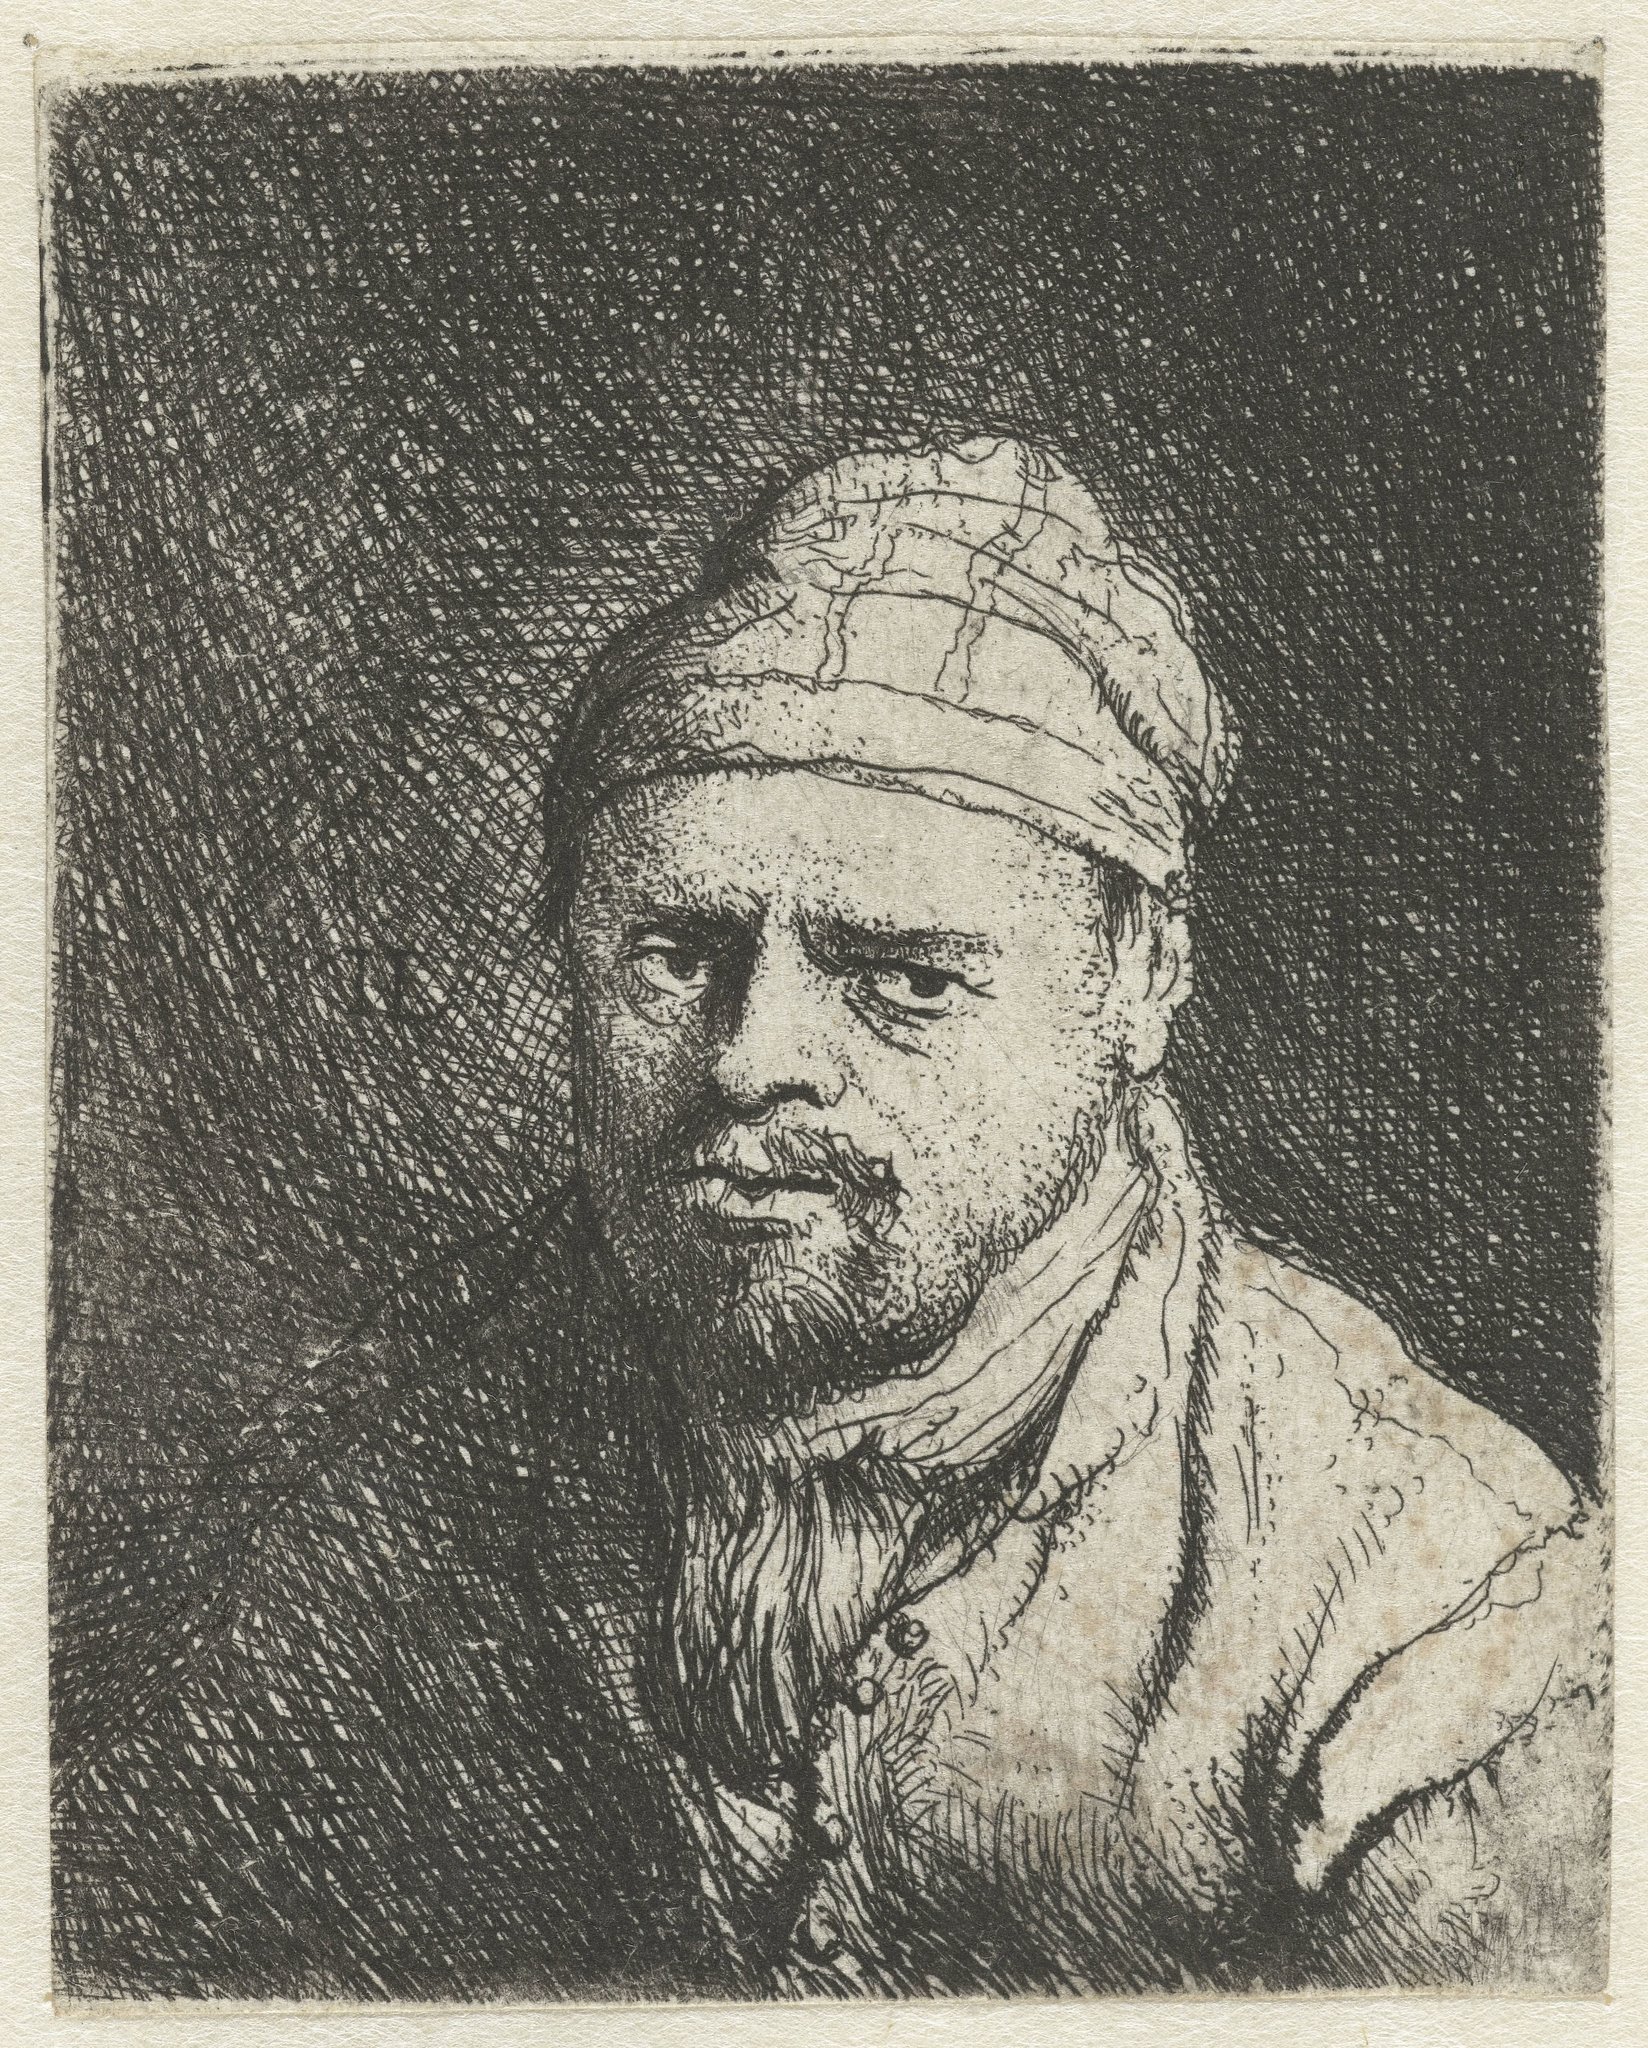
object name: print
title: Diverse Tronikens geetst van I. L.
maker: jan lievens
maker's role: draughtsman, painter, print maker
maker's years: 1607-1674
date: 1625-1674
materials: paper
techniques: etching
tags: head-gear: cap (+ men's clothes), adult man, cook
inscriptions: collector's mark: Lugt 240